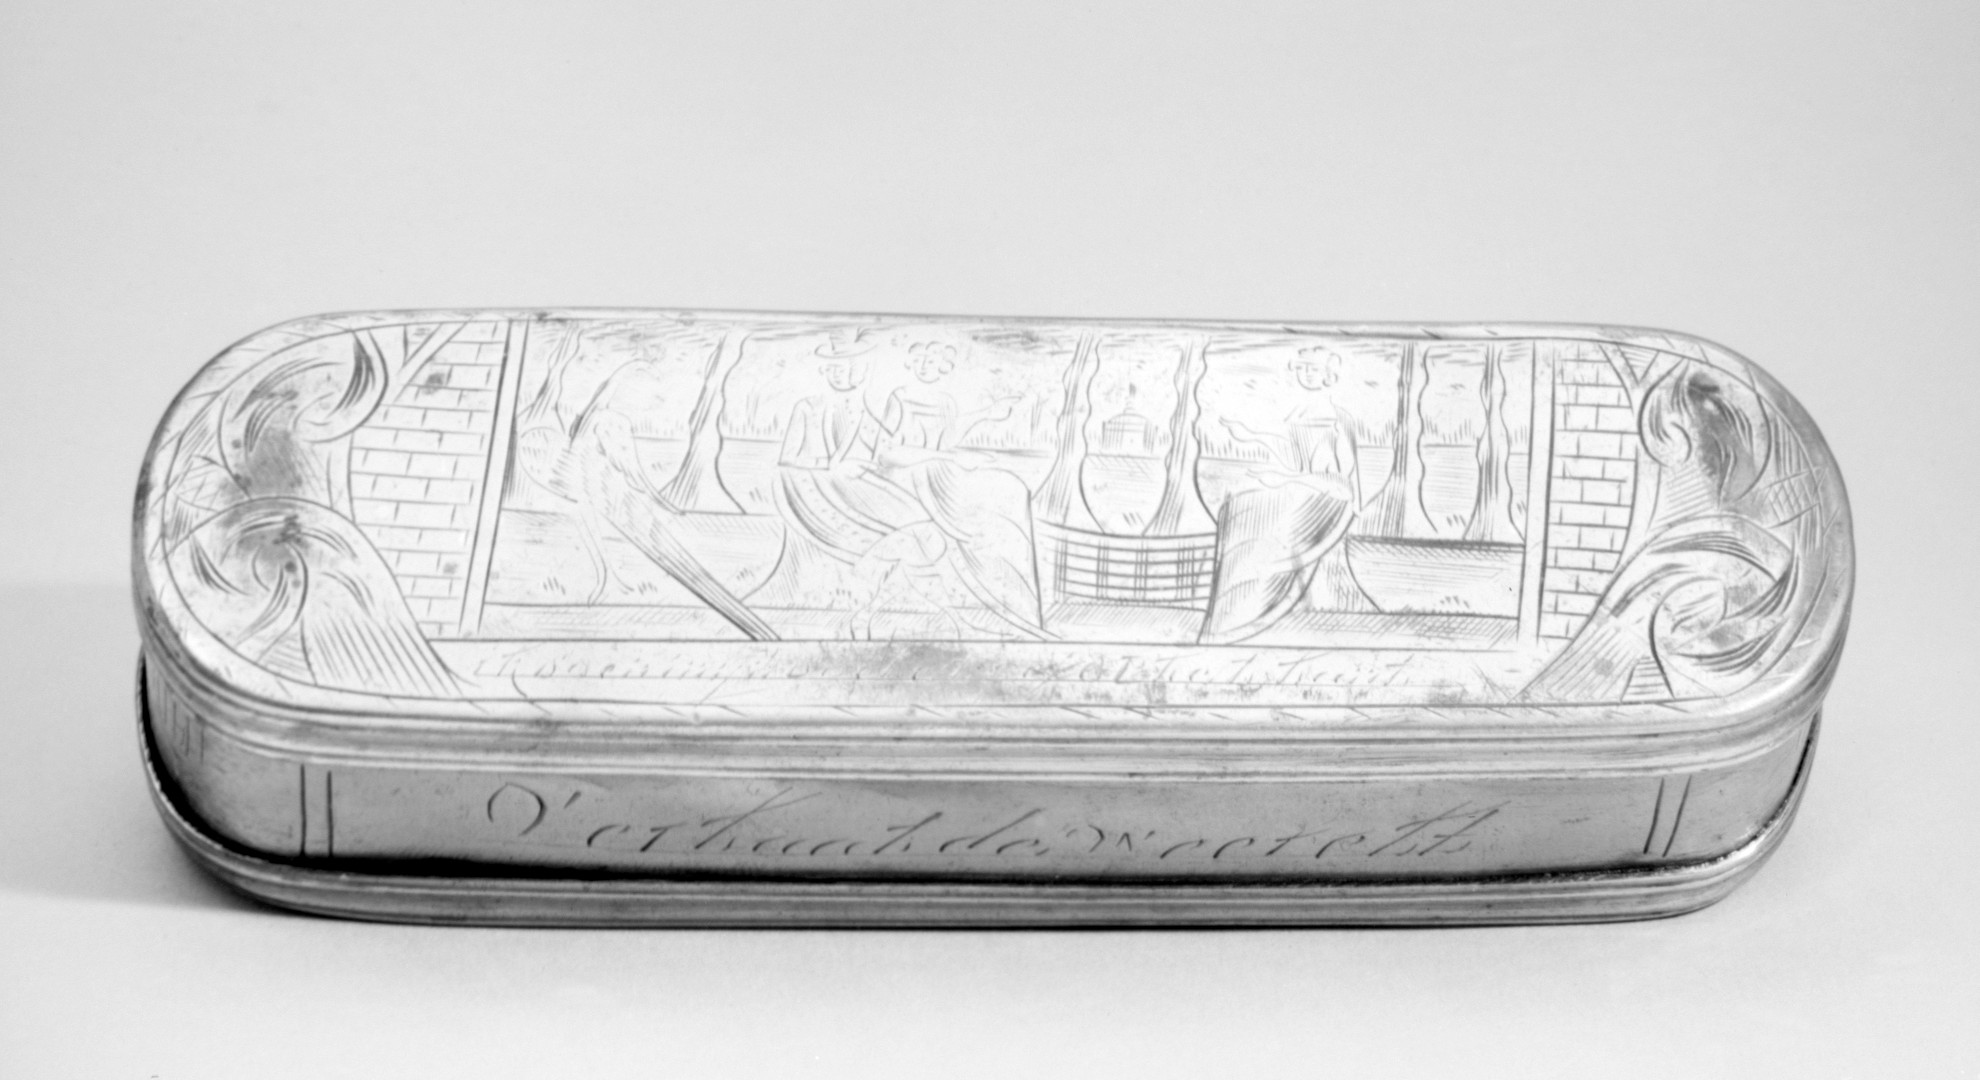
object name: tobacco box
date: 1701-1800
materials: brass, copper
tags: men,women,trees